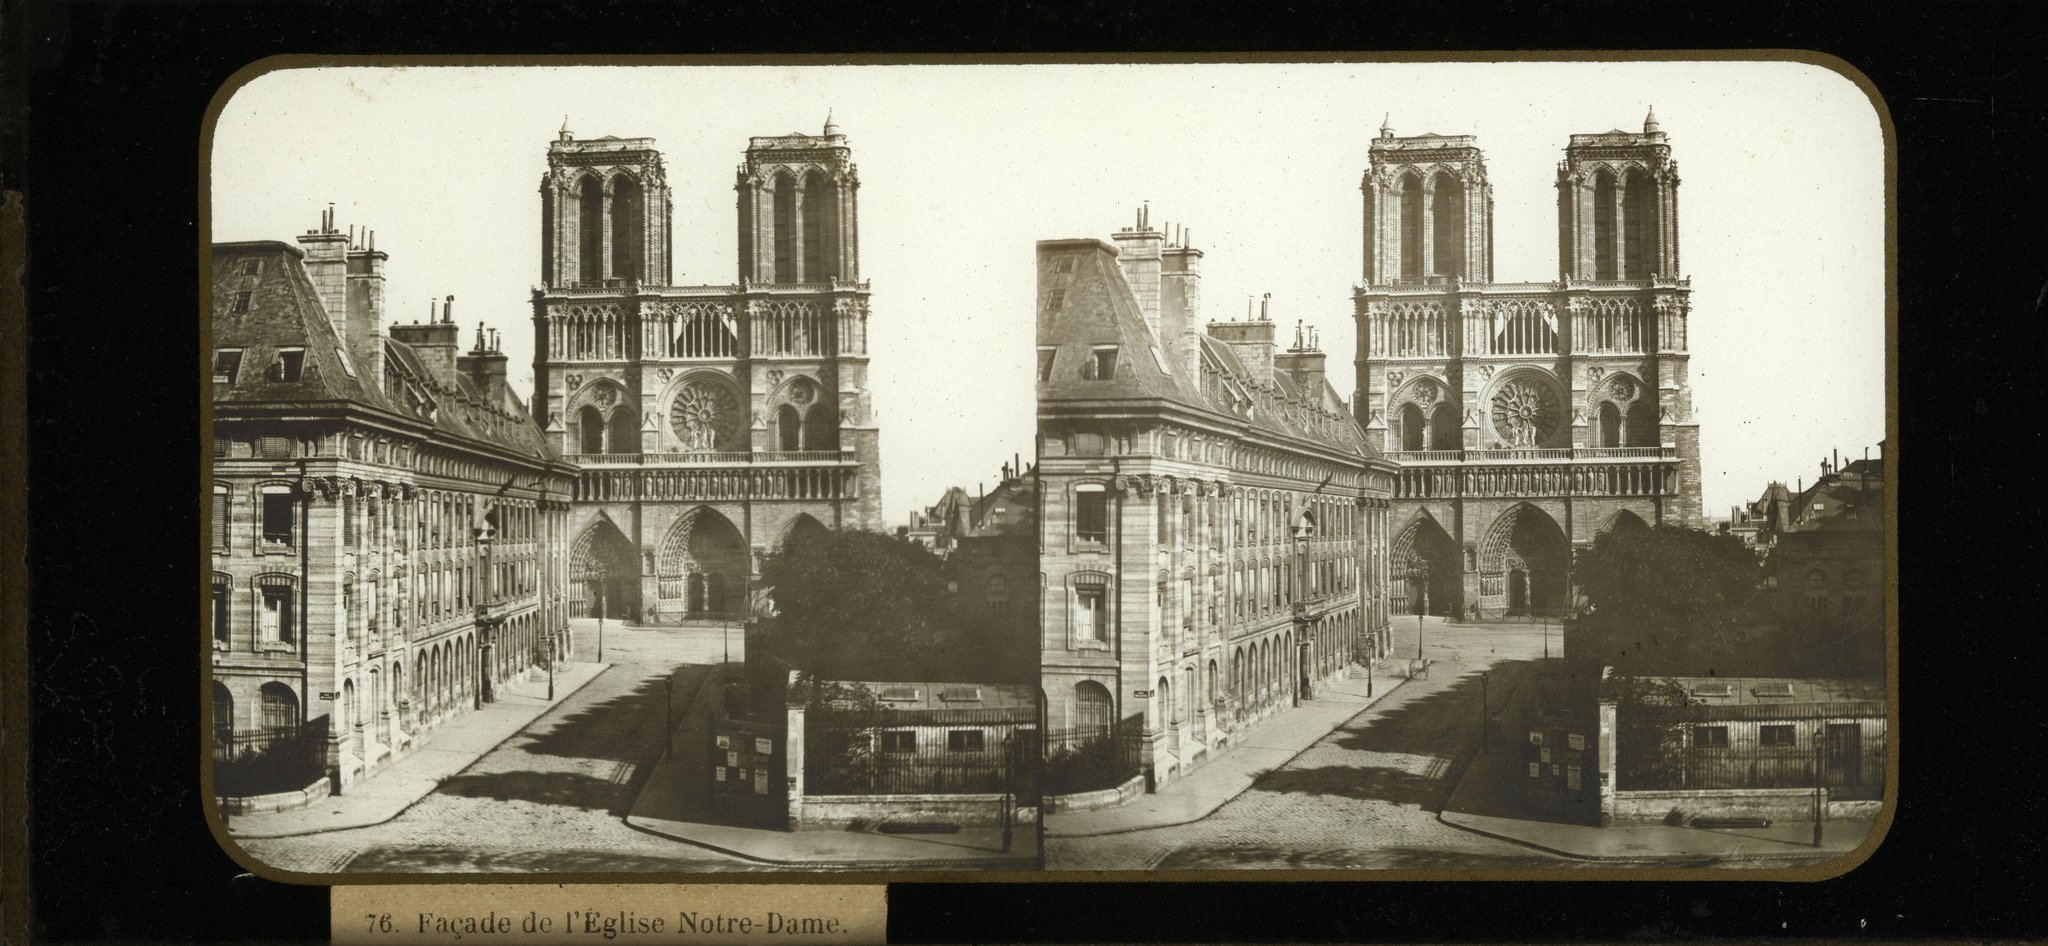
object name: photograph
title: Façade de l'Église Notre-Dame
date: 1855-1865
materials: glass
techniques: photography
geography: paris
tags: church (exterior)